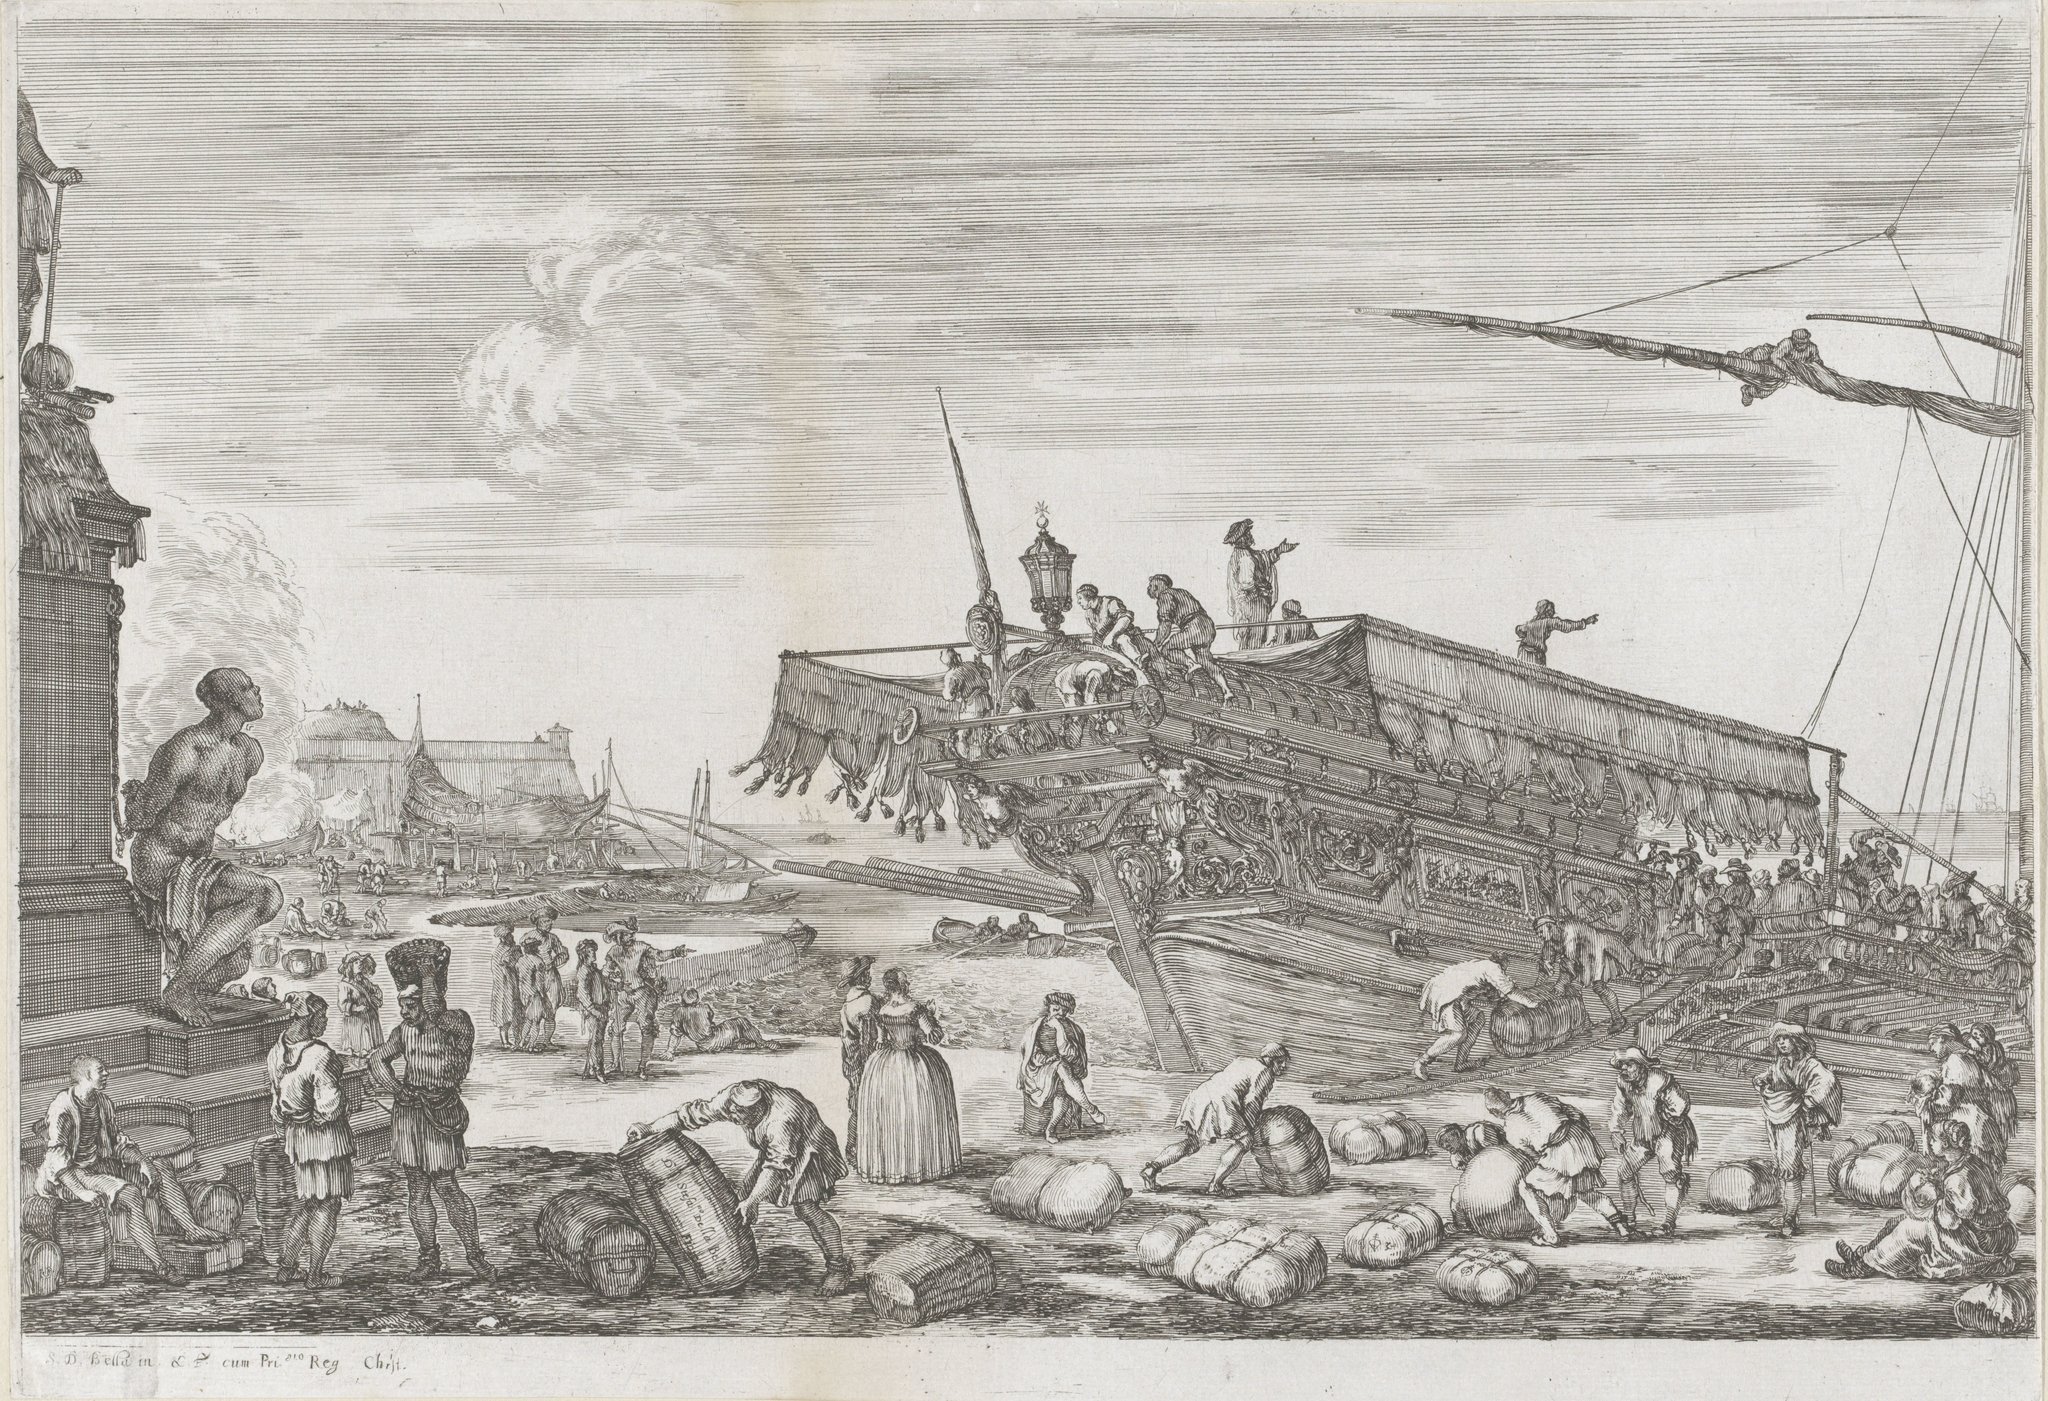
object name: print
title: Inladen van galeischip in de haven van Livorno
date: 1655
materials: paper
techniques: etching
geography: italy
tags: ferdinando i de' medici, harbour, dock labourer, ships (in general), slavery; serfs and enslaved persons, piece of sculpture, reproduction of a piece of sculpture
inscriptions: collector's mark: Lugt 240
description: Zicht op de haven van Livorno met links het standbeeld van Ferdinand I, groothertog van Toscane, en de vier tot slaaf gemaakte 'Moren' (I Quattro Mori). Rechts wordt een galeischip van de Orde van de heilige Stefanus ingeladen door havenarbeiders. Op de achtergrond links een muur en twee schepen op de kade.